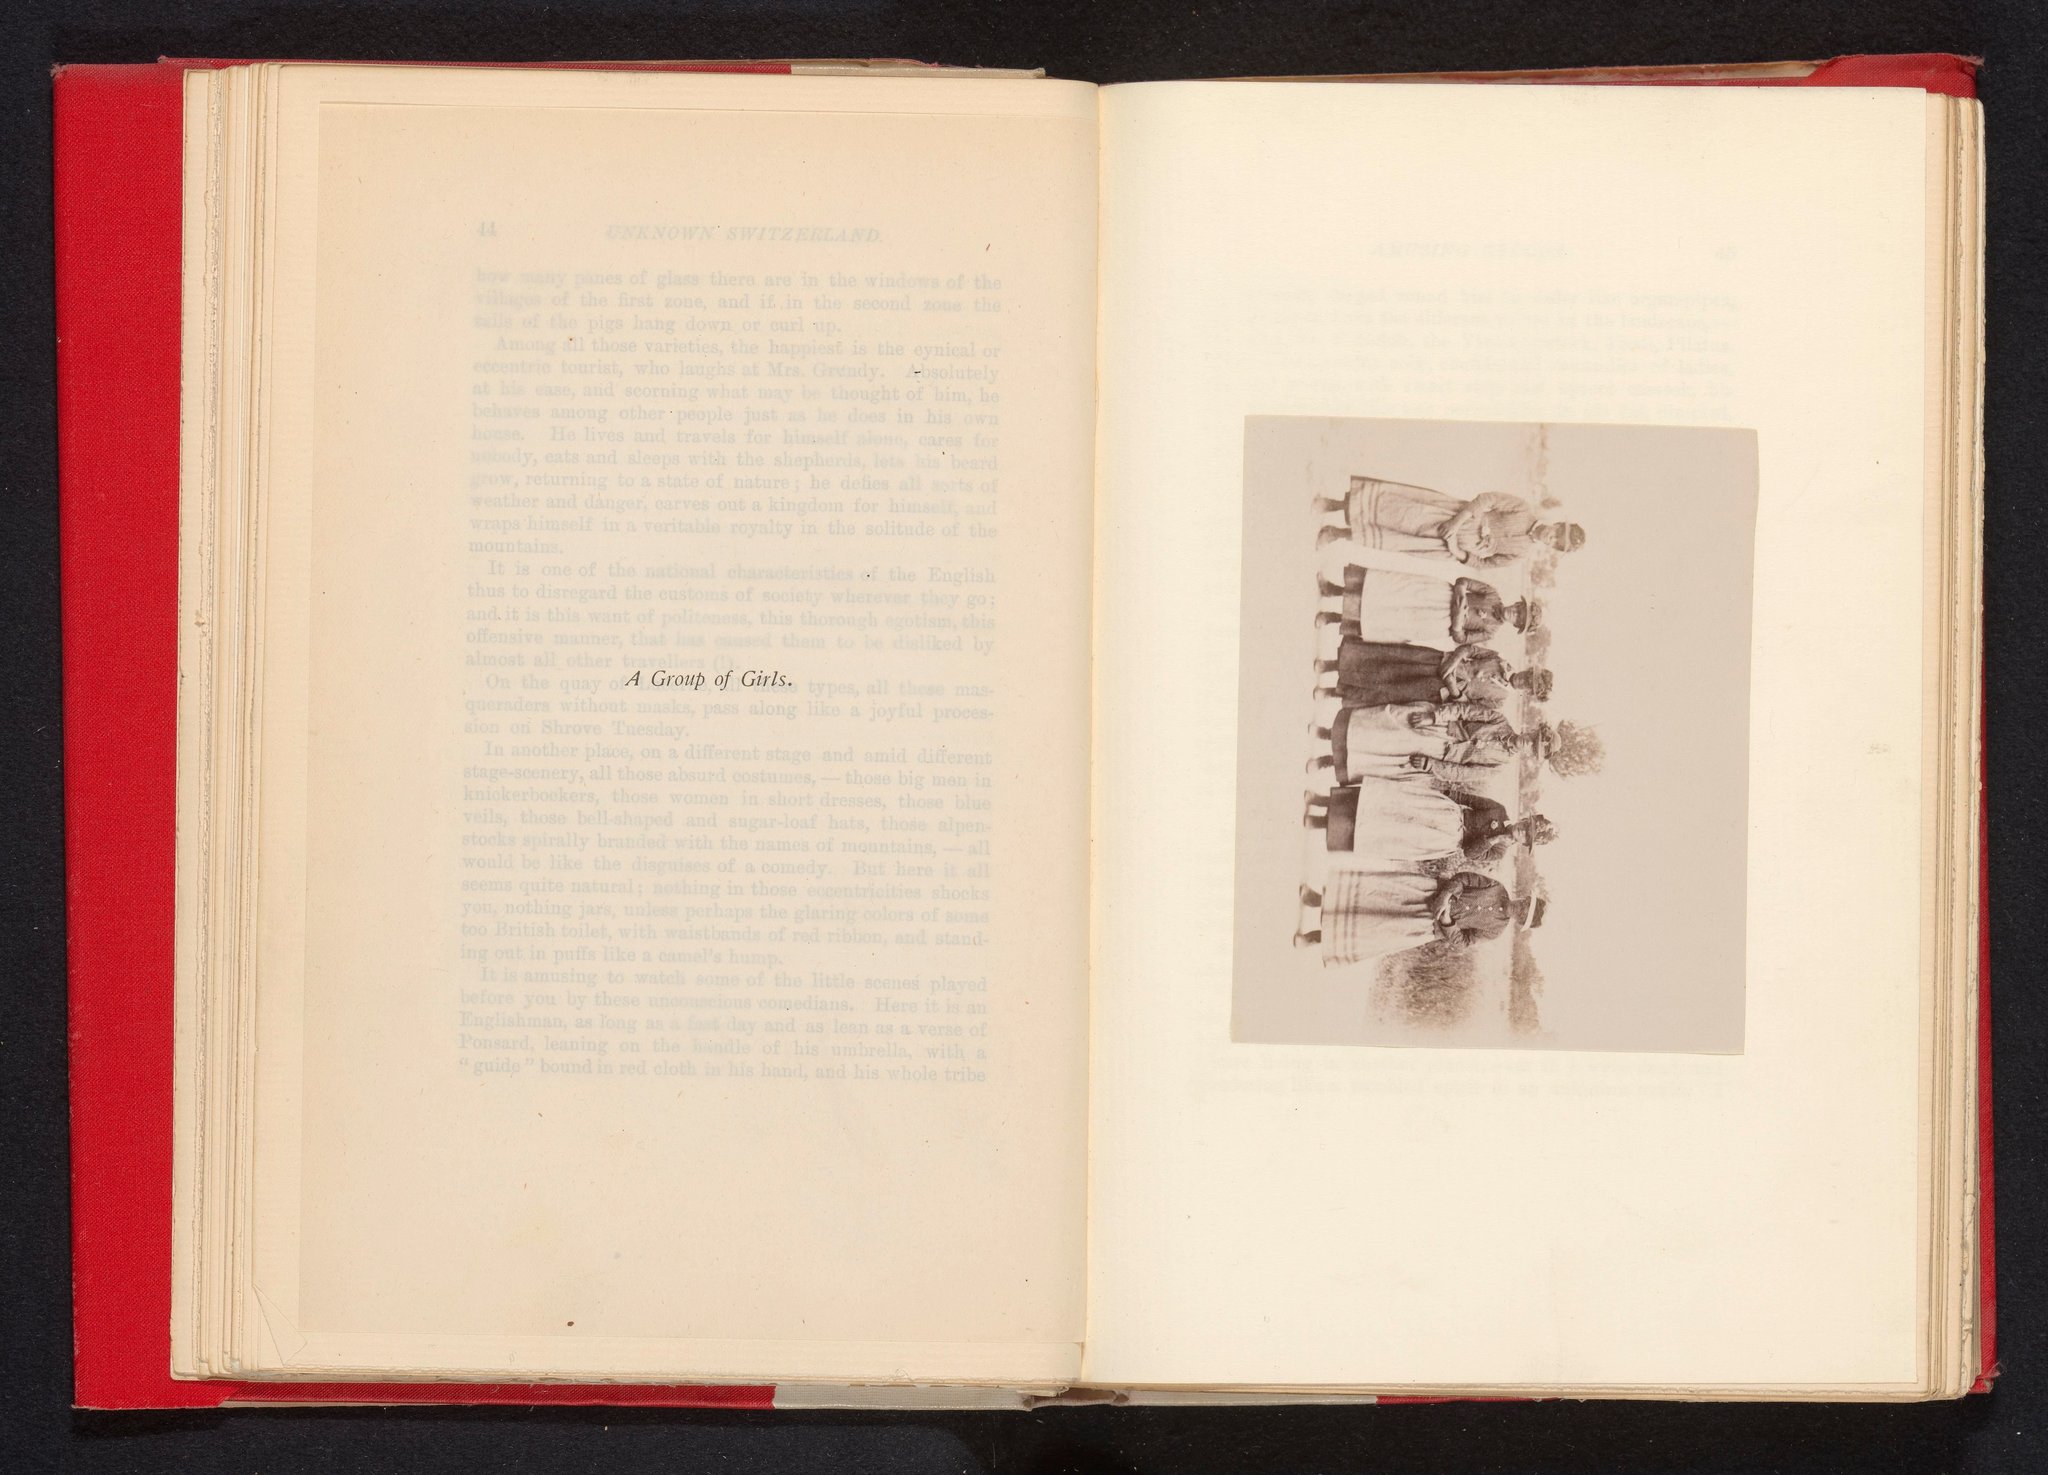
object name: page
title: Portret van zes onbekende vrouwen of meisjes uit Zwitserland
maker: Anonymous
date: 1879-1889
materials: photographic support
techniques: albumen print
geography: switzerland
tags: adolescent, young woman, maiden, adult woman, switzerland